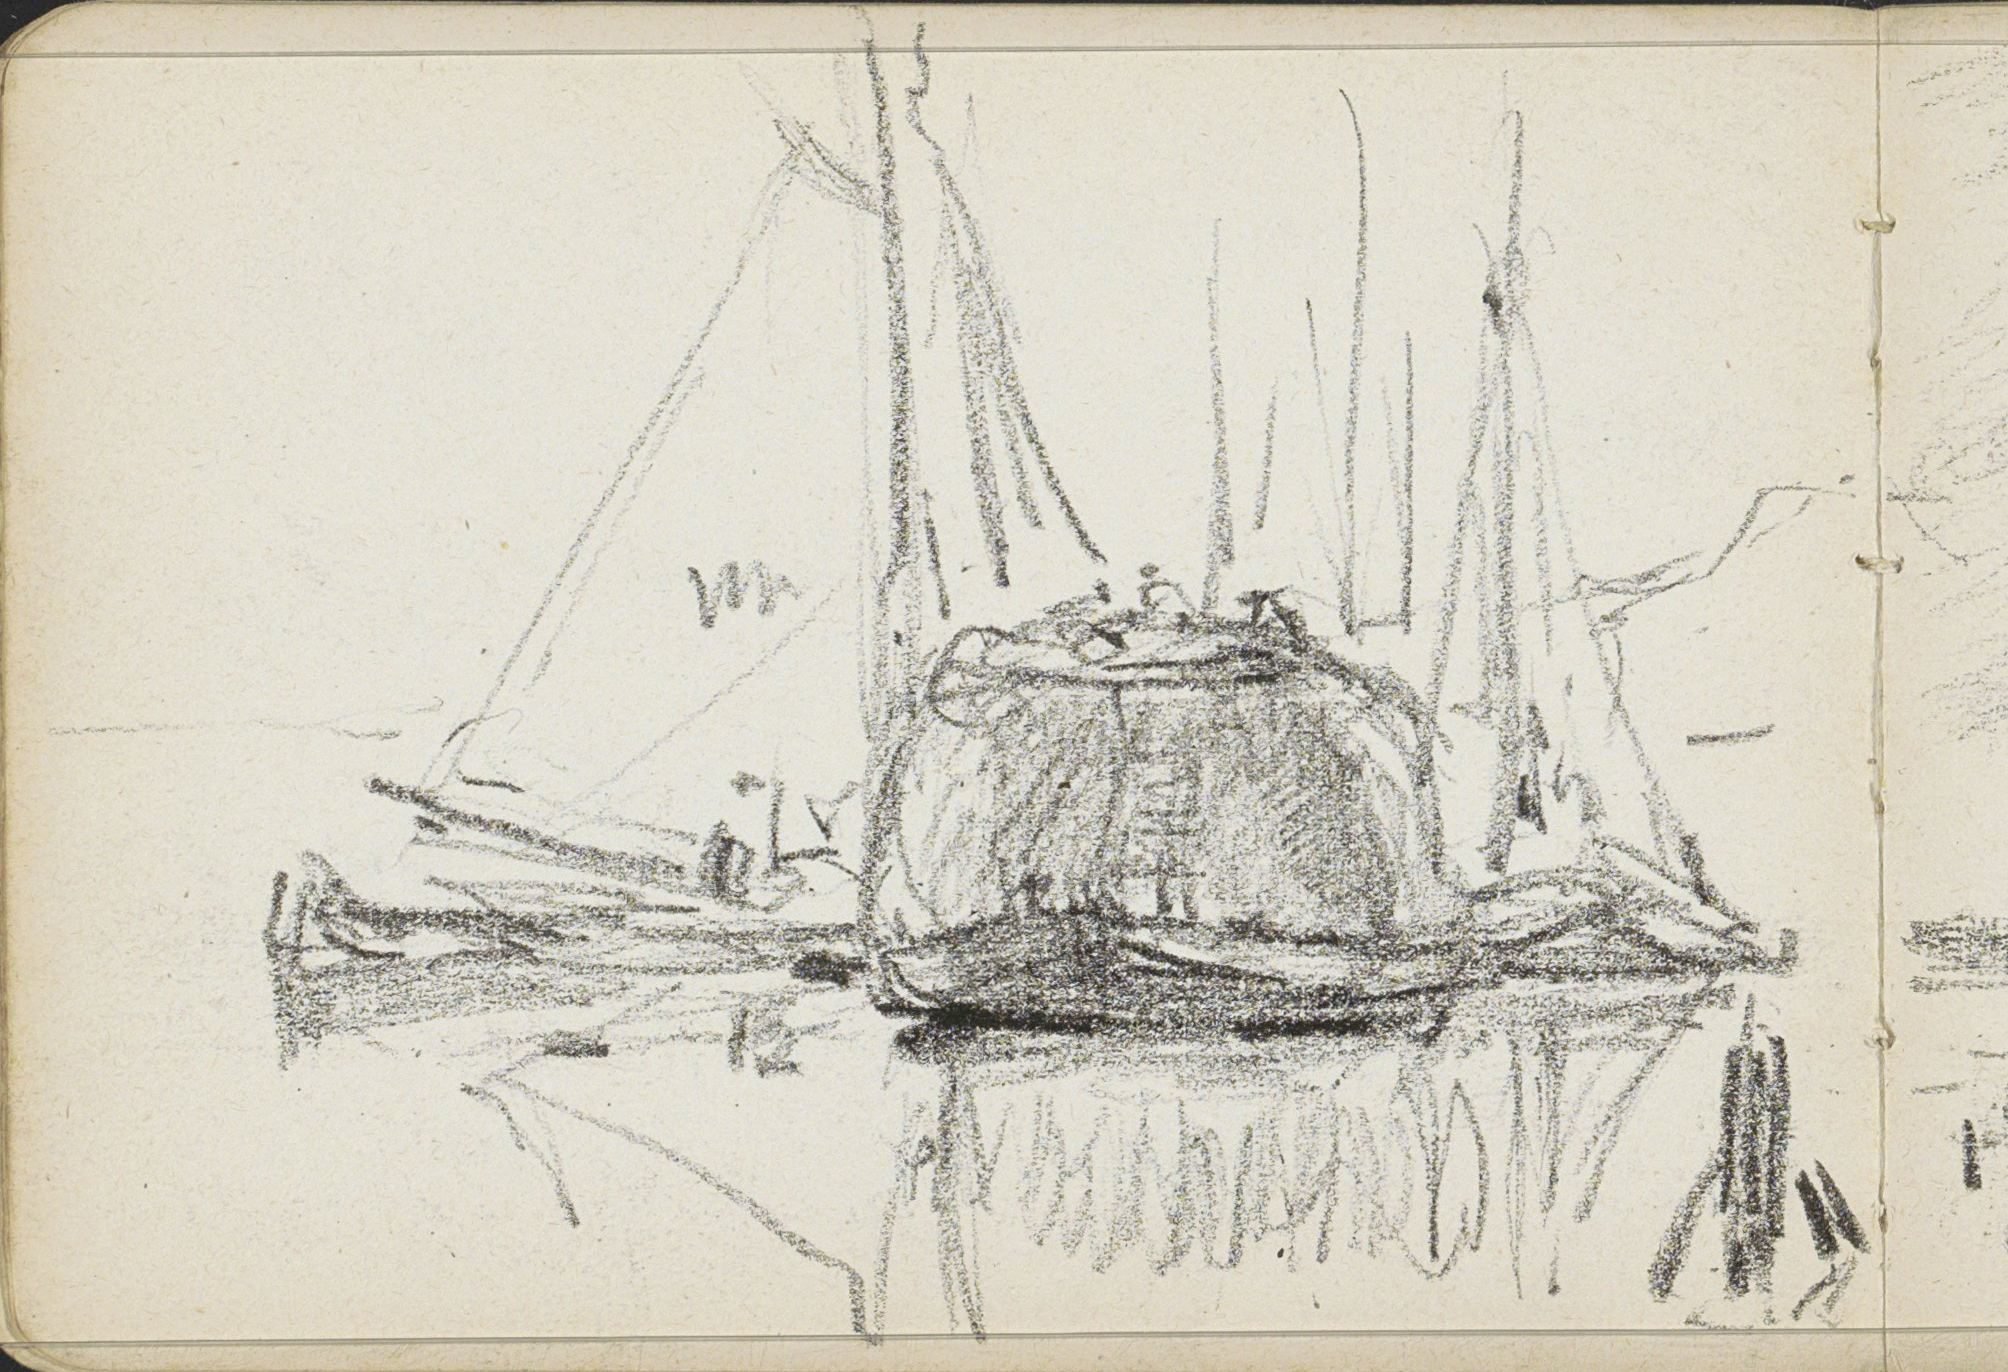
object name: sketchbook leaf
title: Zeilboten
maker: willem cornelis rip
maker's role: draughtsman, painter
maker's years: 1856-1922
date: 1866-1922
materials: chalk, paper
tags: sailing-ship, sailing-boat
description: Blad 4 verso uit een schetsboek met 42 bladen.